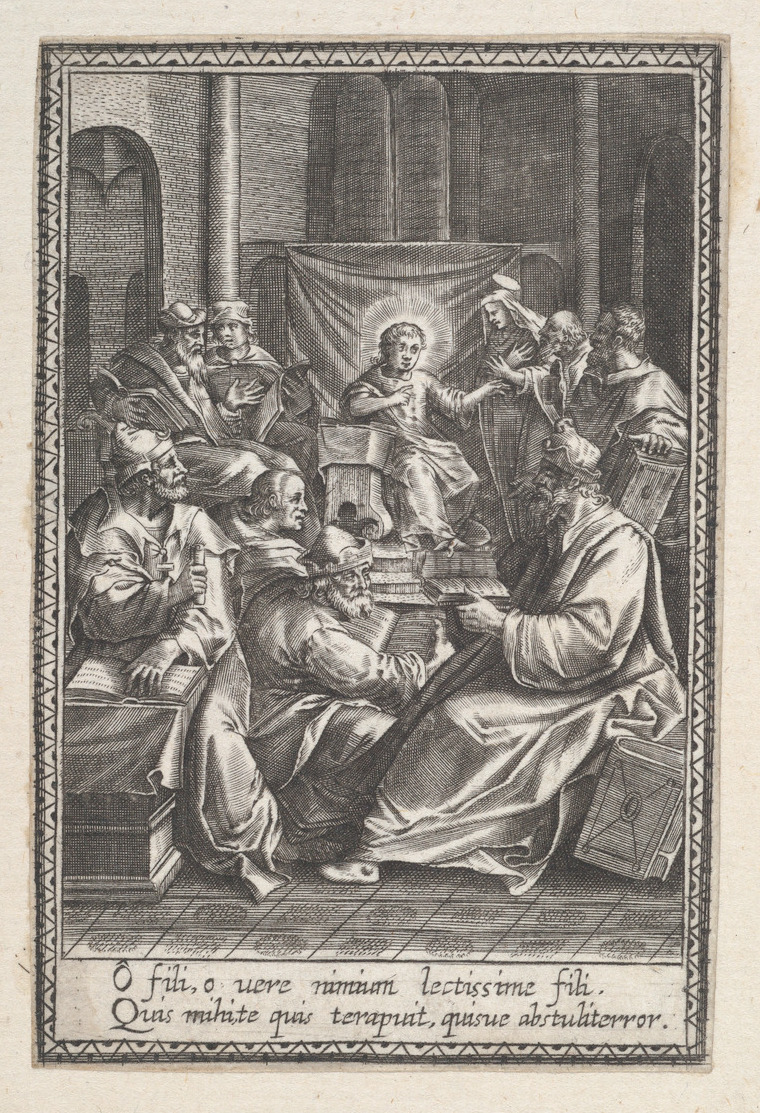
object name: print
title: Christ Among the Doctors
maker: Anonymous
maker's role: artist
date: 1590-1620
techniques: engraving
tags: men,christ,doctors